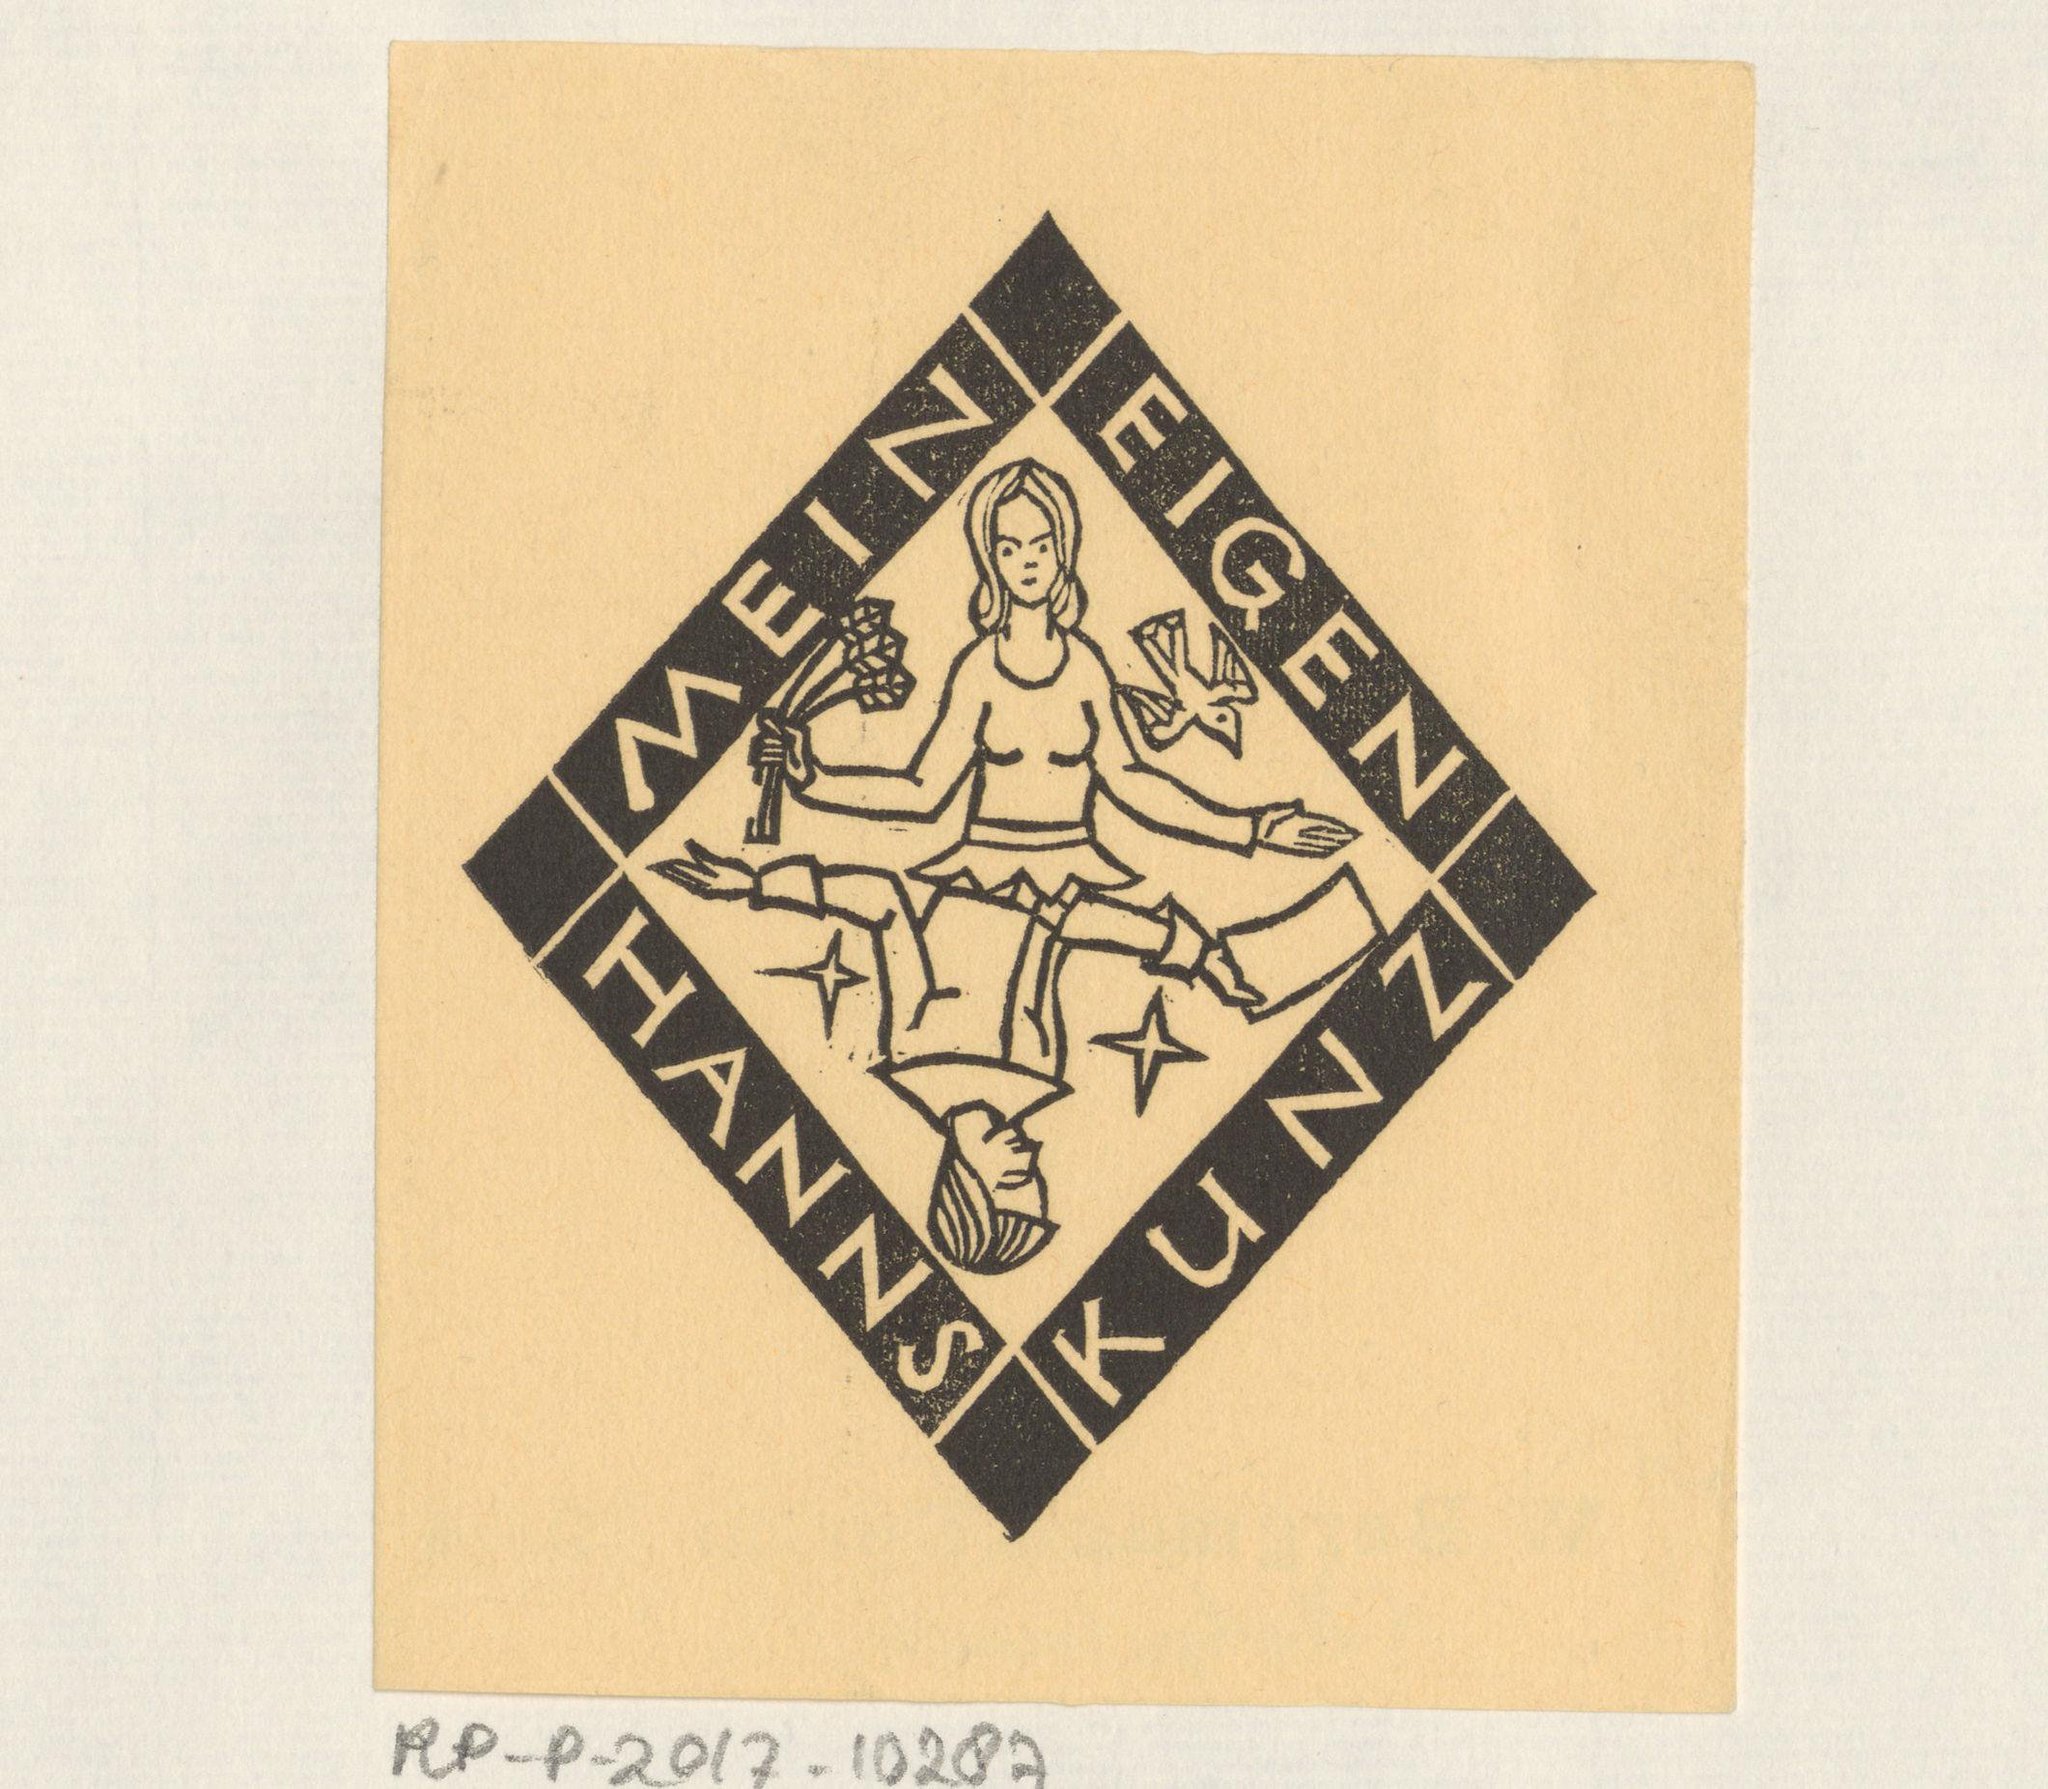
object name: bookplate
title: Ex libris van Hanns Kunz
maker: w. bergmann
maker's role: print maker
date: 1924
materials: paper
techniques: woodcut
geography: berlin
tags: standing figure, reading, birds, standing figure - aa - female human figure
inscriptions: workshop stamp: ‘W. Bergmann Berlin 1924’